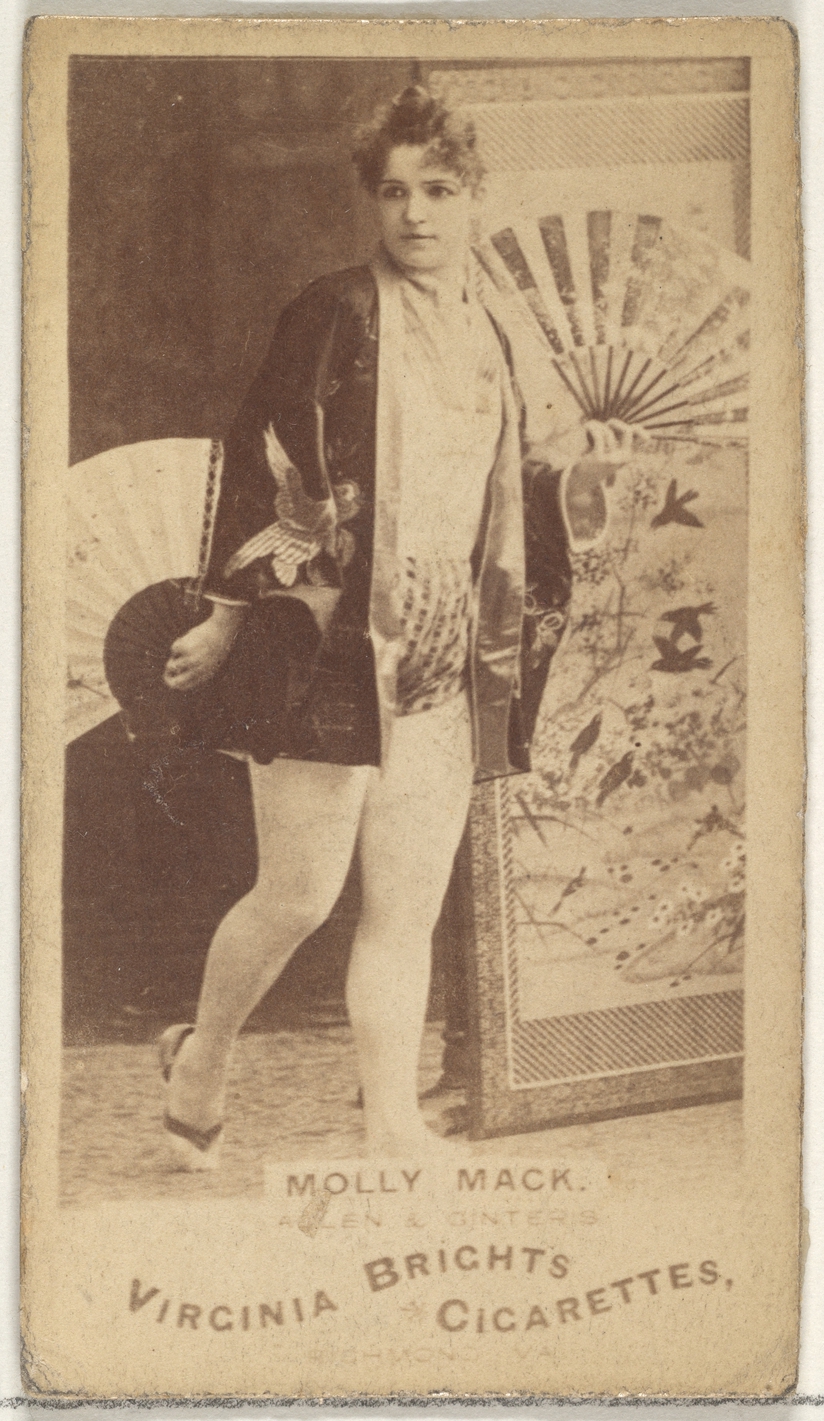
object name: photograph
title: Molly Mack, from the Actors and Actresses series (N45, Type 1) for Virginia Brights Cigarettes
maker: allen & ginter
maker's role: publisher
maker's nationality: american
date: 1888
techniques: albumen silver print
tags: fans,portraits,women,actresses